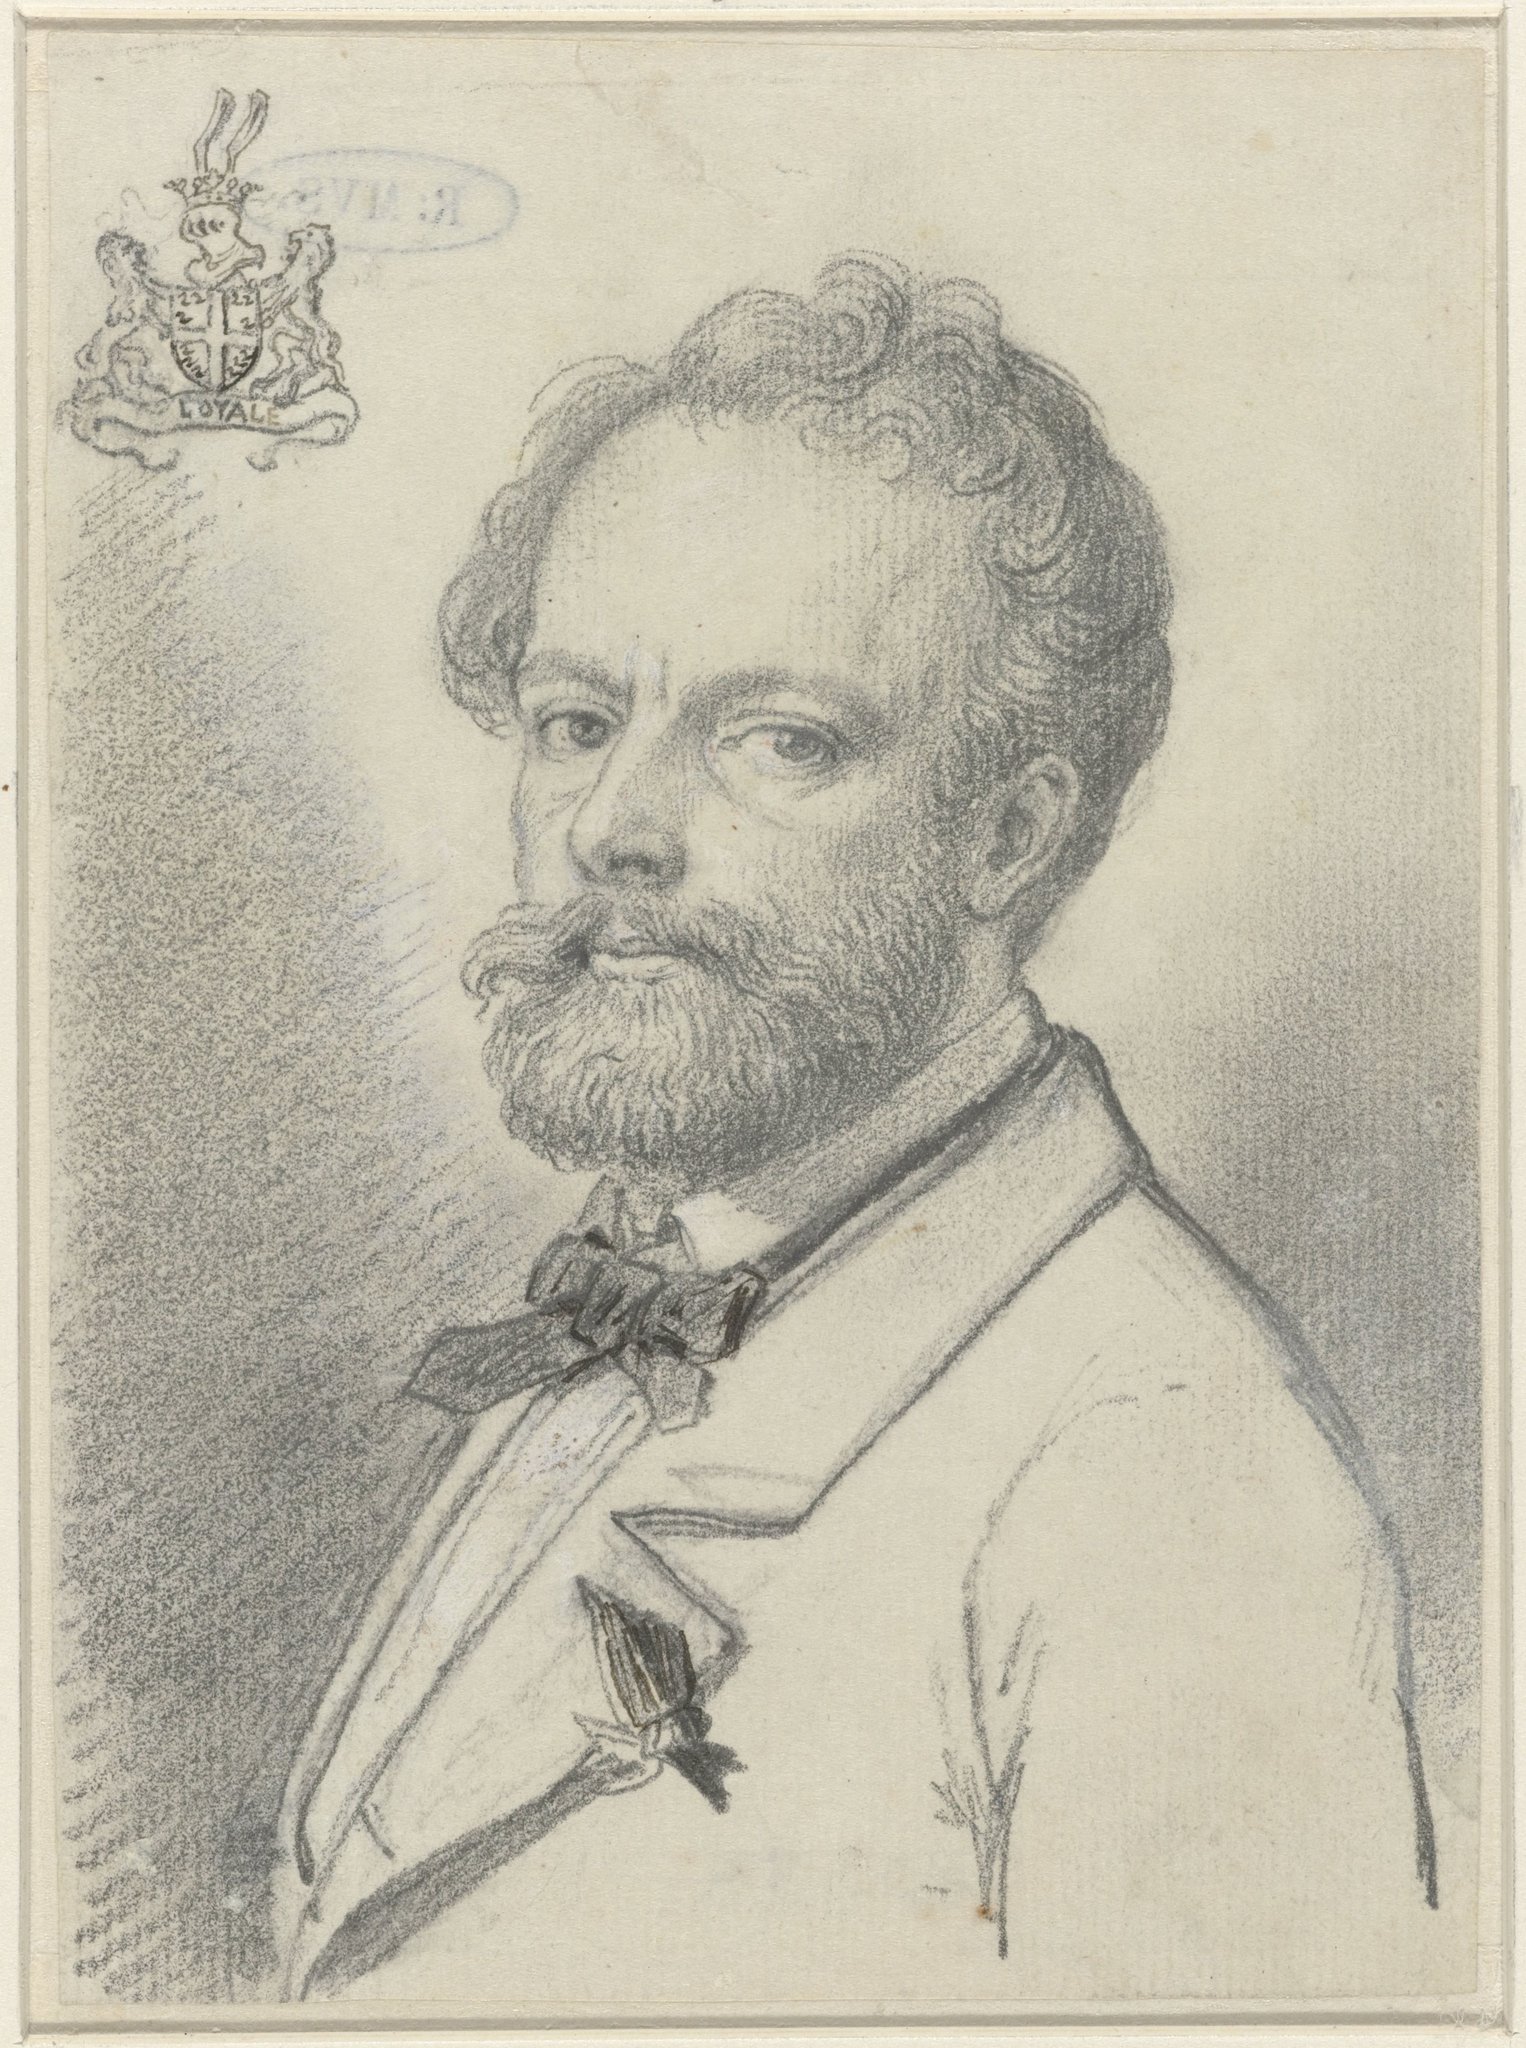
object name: drawing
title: Zelfportret van Eugène van Maldeghem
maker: eugène van maldeghem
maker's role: draughtsman, painter, print maker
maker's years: 1813-1867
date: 1823-1867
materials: ink, paper, pencil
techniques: pen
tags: painter, eugène van maldeghem, historical persons, portrait, self-portrait of artist